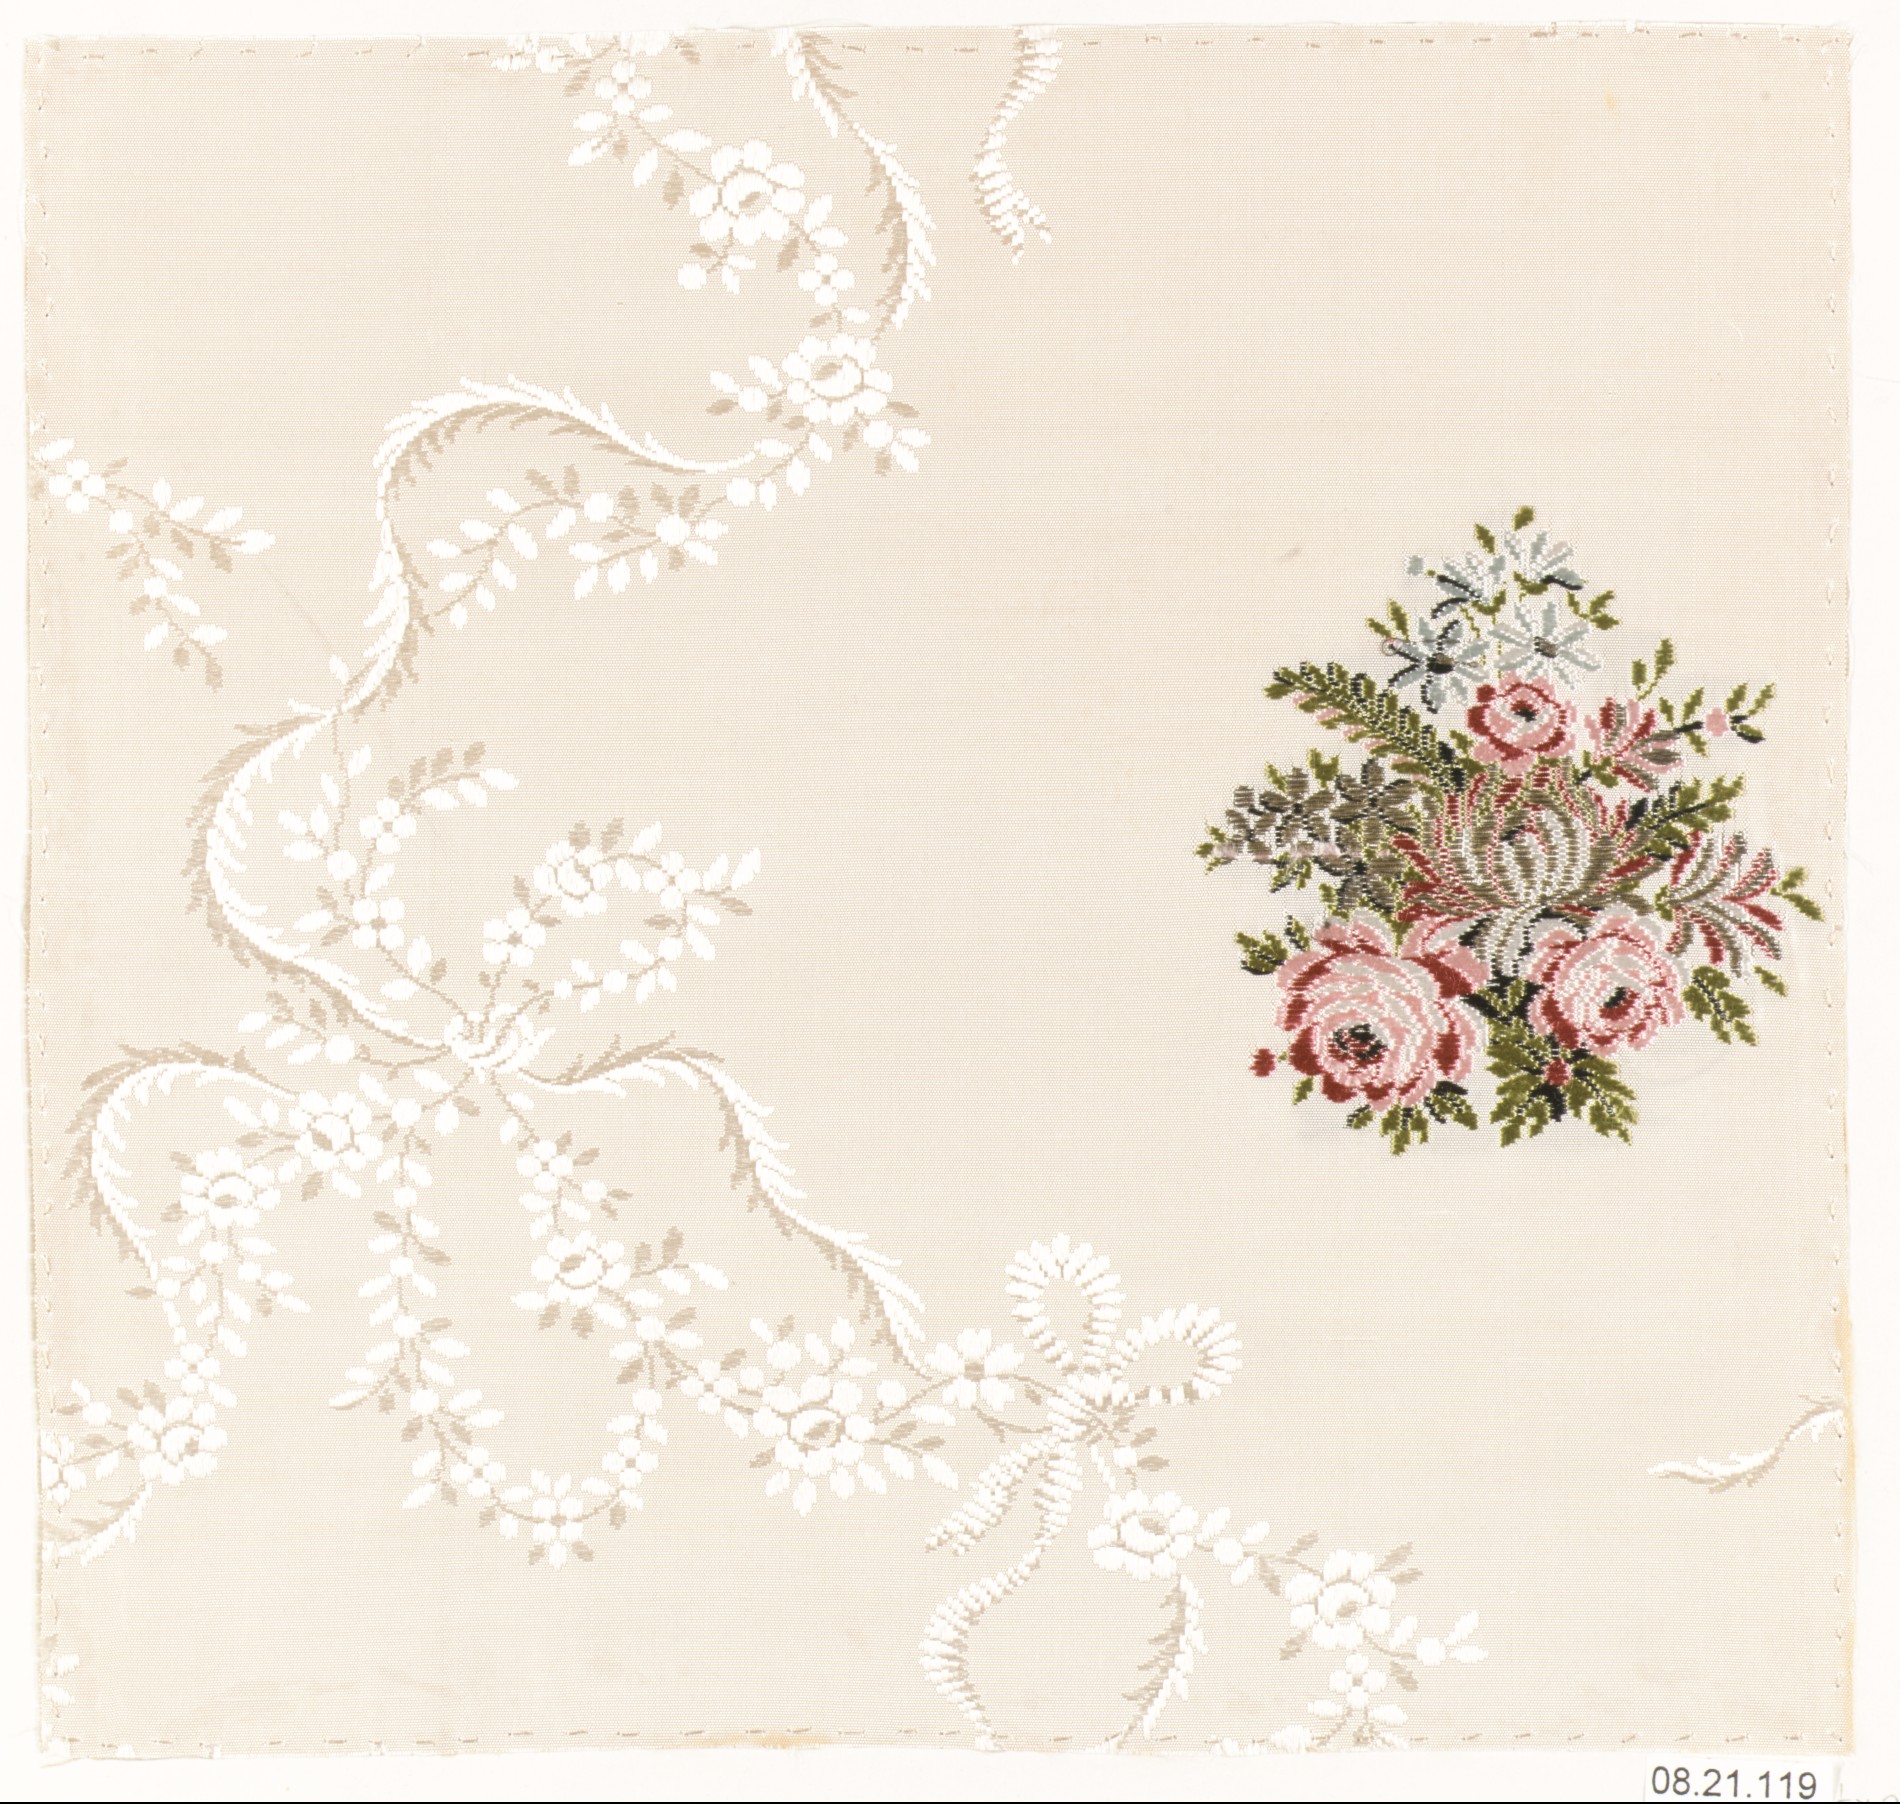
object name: textile sample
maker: Anonymous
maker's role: designer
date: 1900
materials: silk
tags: flowers